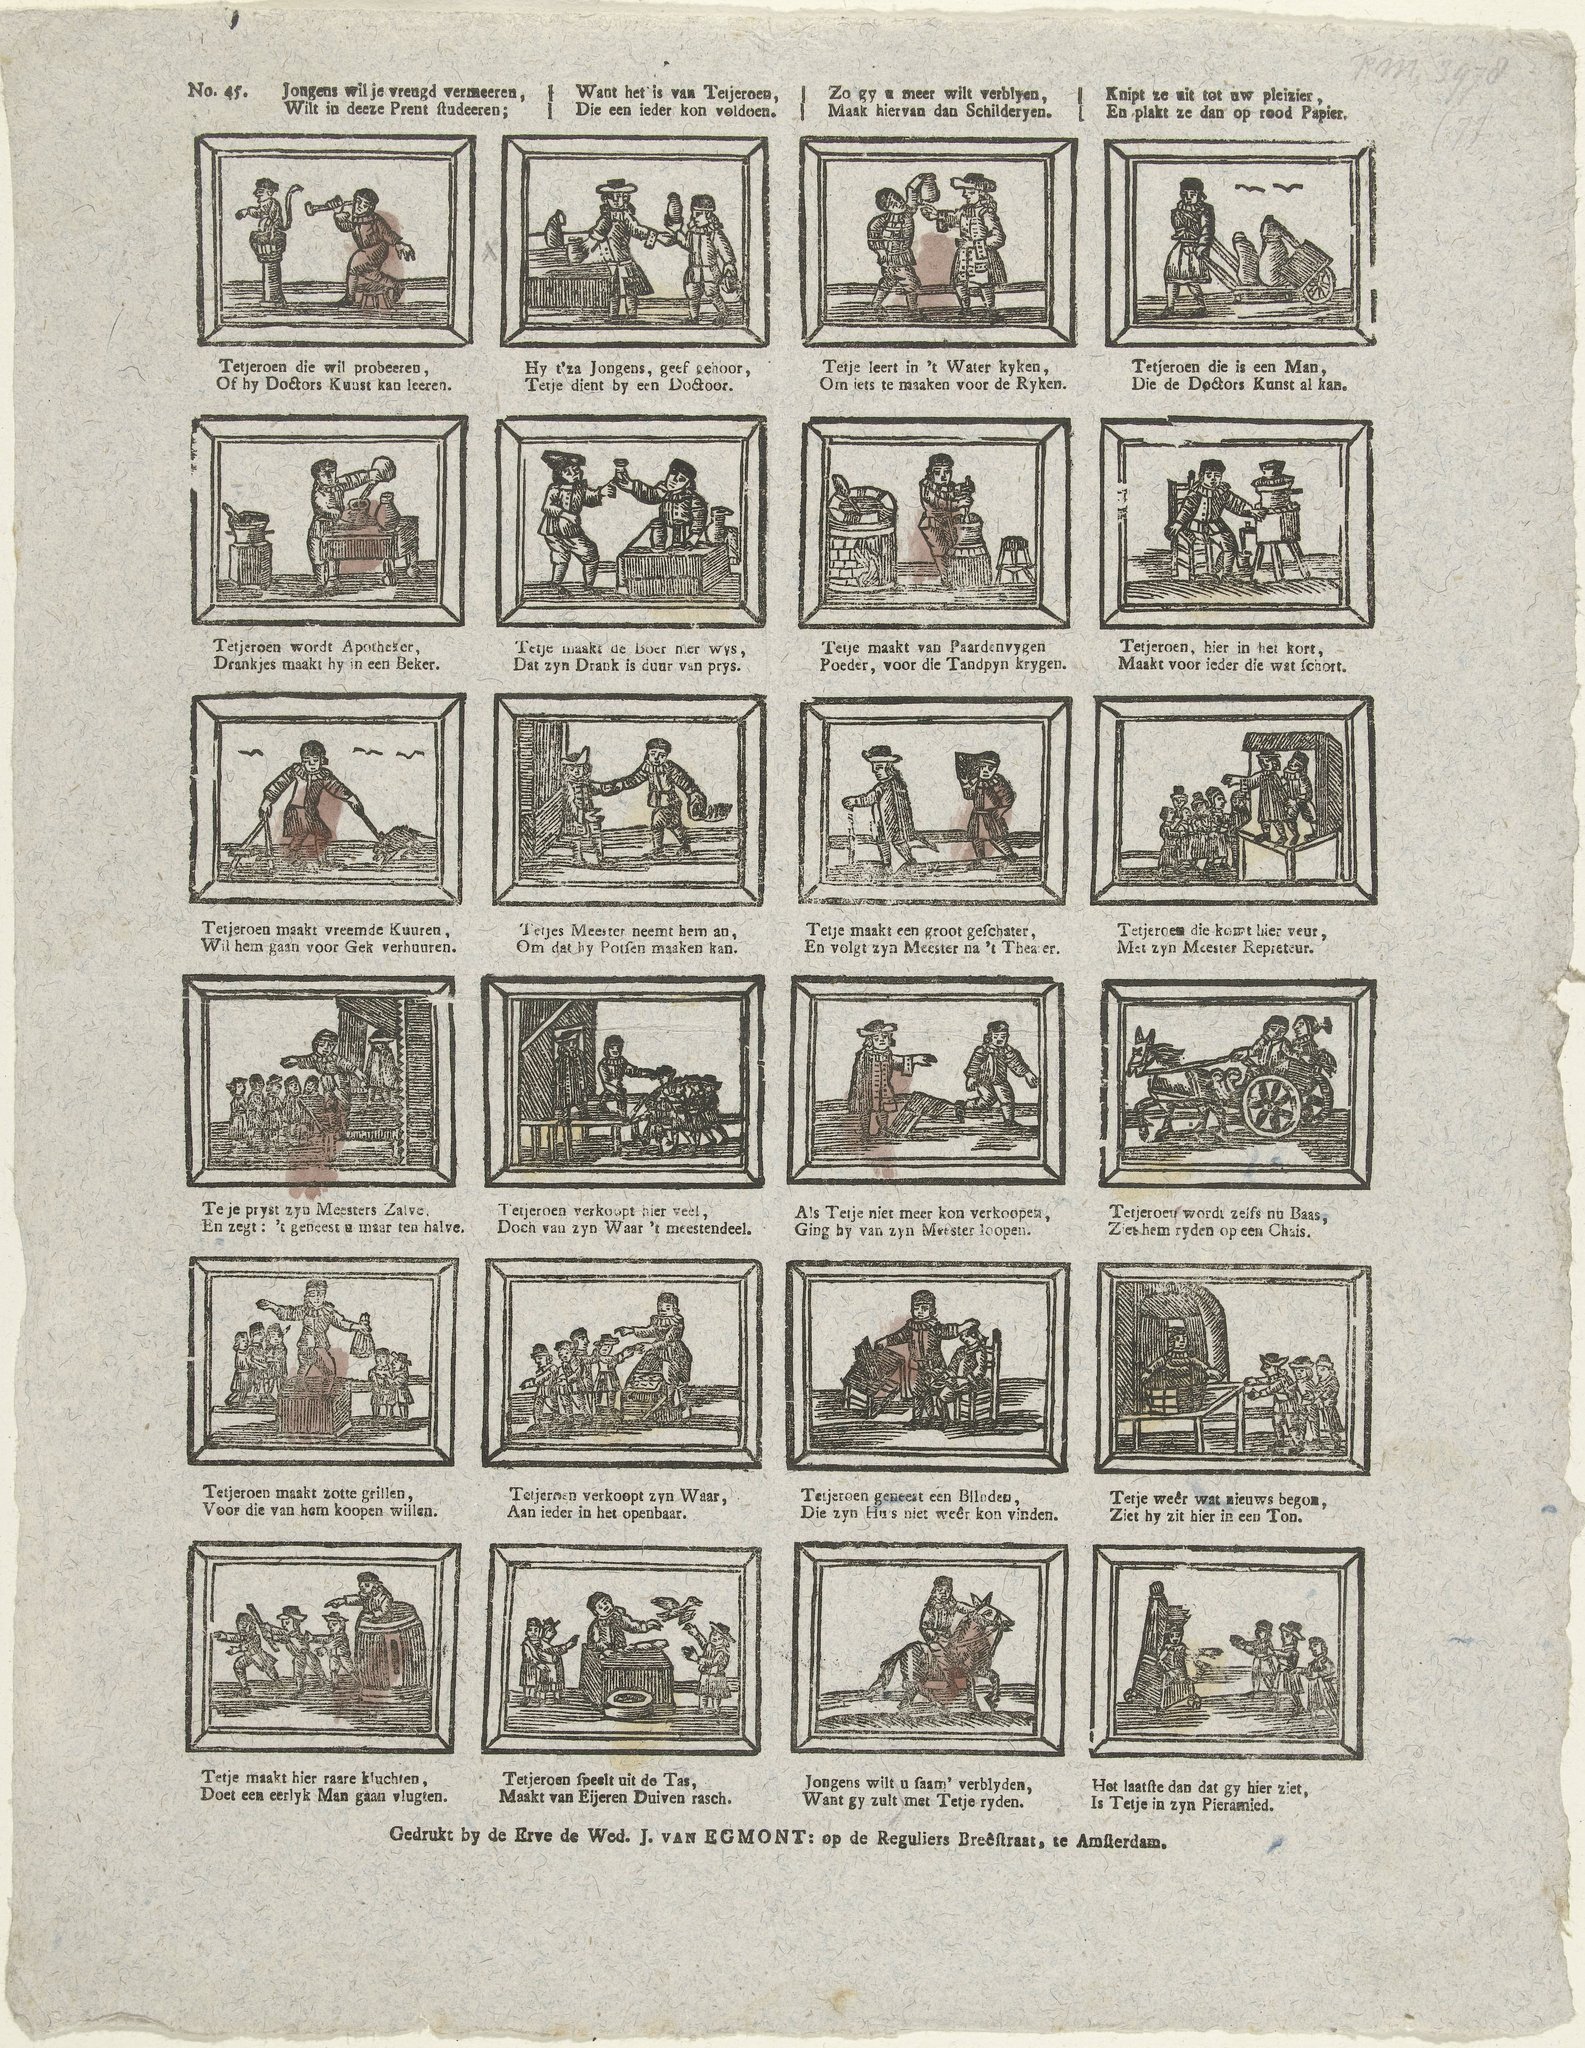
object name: popular print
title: Jongens wil je vreugd vermeeren, / Wilt in deeze Prent studeeren (...)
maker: Anonymous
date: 1761-1804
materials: paper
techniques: colour, letterpress printing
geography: amsterdam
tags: quack, charlatan, mountebank, 'saltimbanco', tales and fairy tales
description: Blad met 24 voorstellingen over het leven van de kwakzalver en grappenmaker Tetjeroen. Hij gaat in de leer bij een dokter, klopt boeren geld uit de zak, kookt drankjes van paardenvijgen en gaat met zijn liefje in een koets rijden. Onder elke afbeelding een tweeregelig vers. Genummerd linksboven: No. 45.